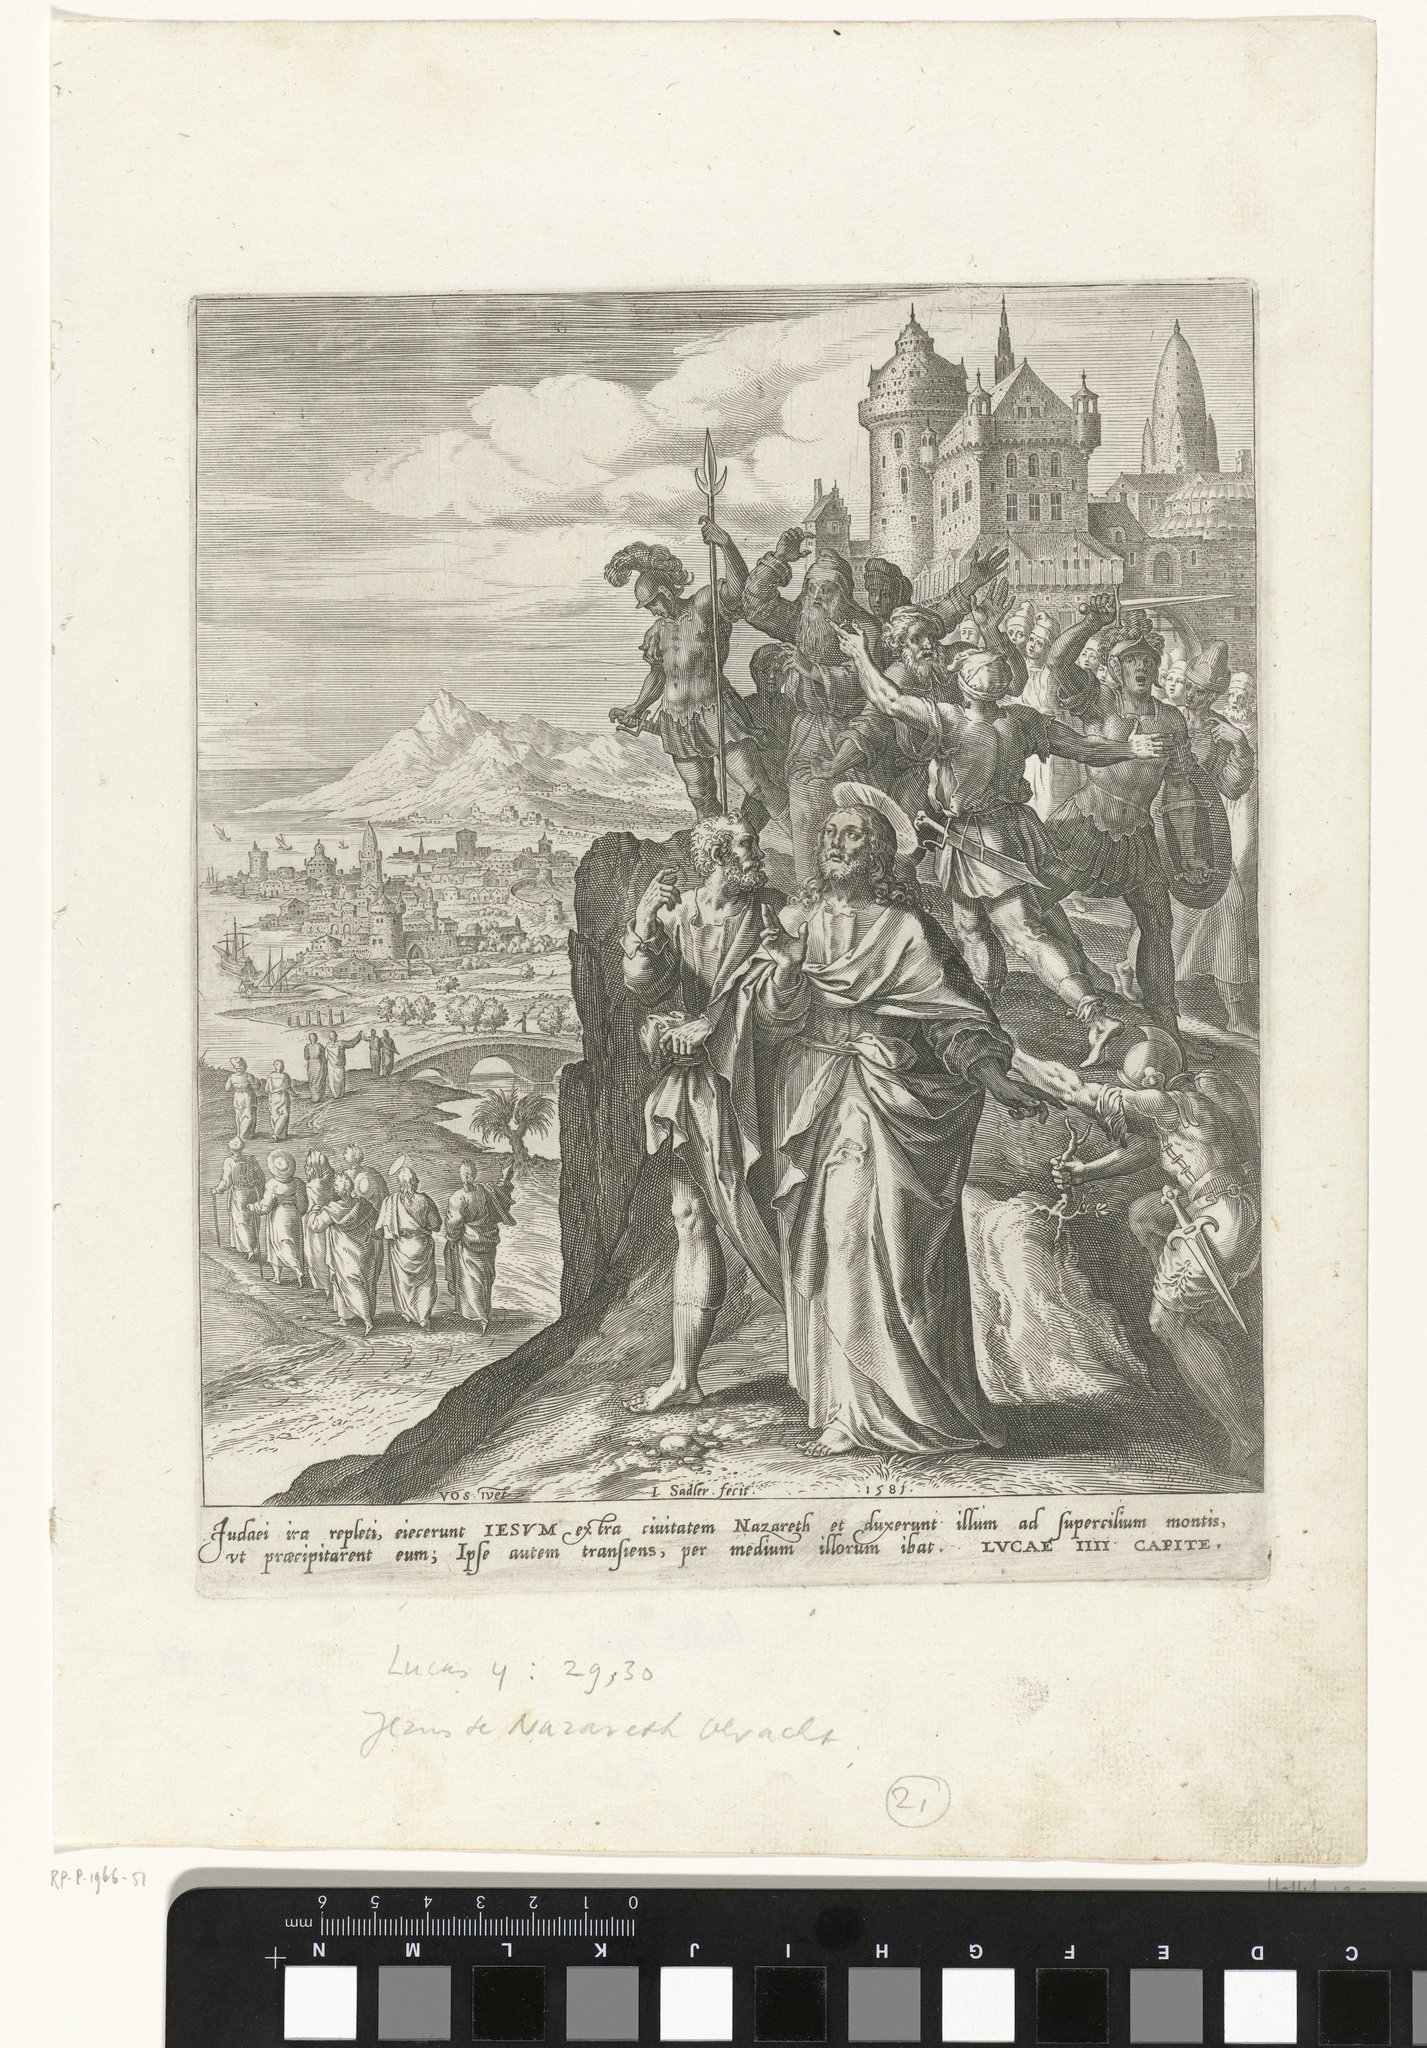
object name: print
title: Inwoners van Nazareth verdrijven Christus uit de stad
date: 1581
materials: paper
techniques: engraving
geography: cologne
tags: christ, having been chased out of nazareth, passes unharmed through the multitude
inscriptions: collector's mark: Lugt 2228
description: Op de voorgrond een ravijn met Christus naast Petrus. Rechts op het tweede plan de inwoners van Nazareth die Christus uitjouwen en uit hun stad drijven. Op de achtergrond links zet Christus zijn reis door Israël voort. De prent heeft een Latijns onderschrift met een Bijbeltekst (Luc. 4) en is de derde prent van een serie van vier.